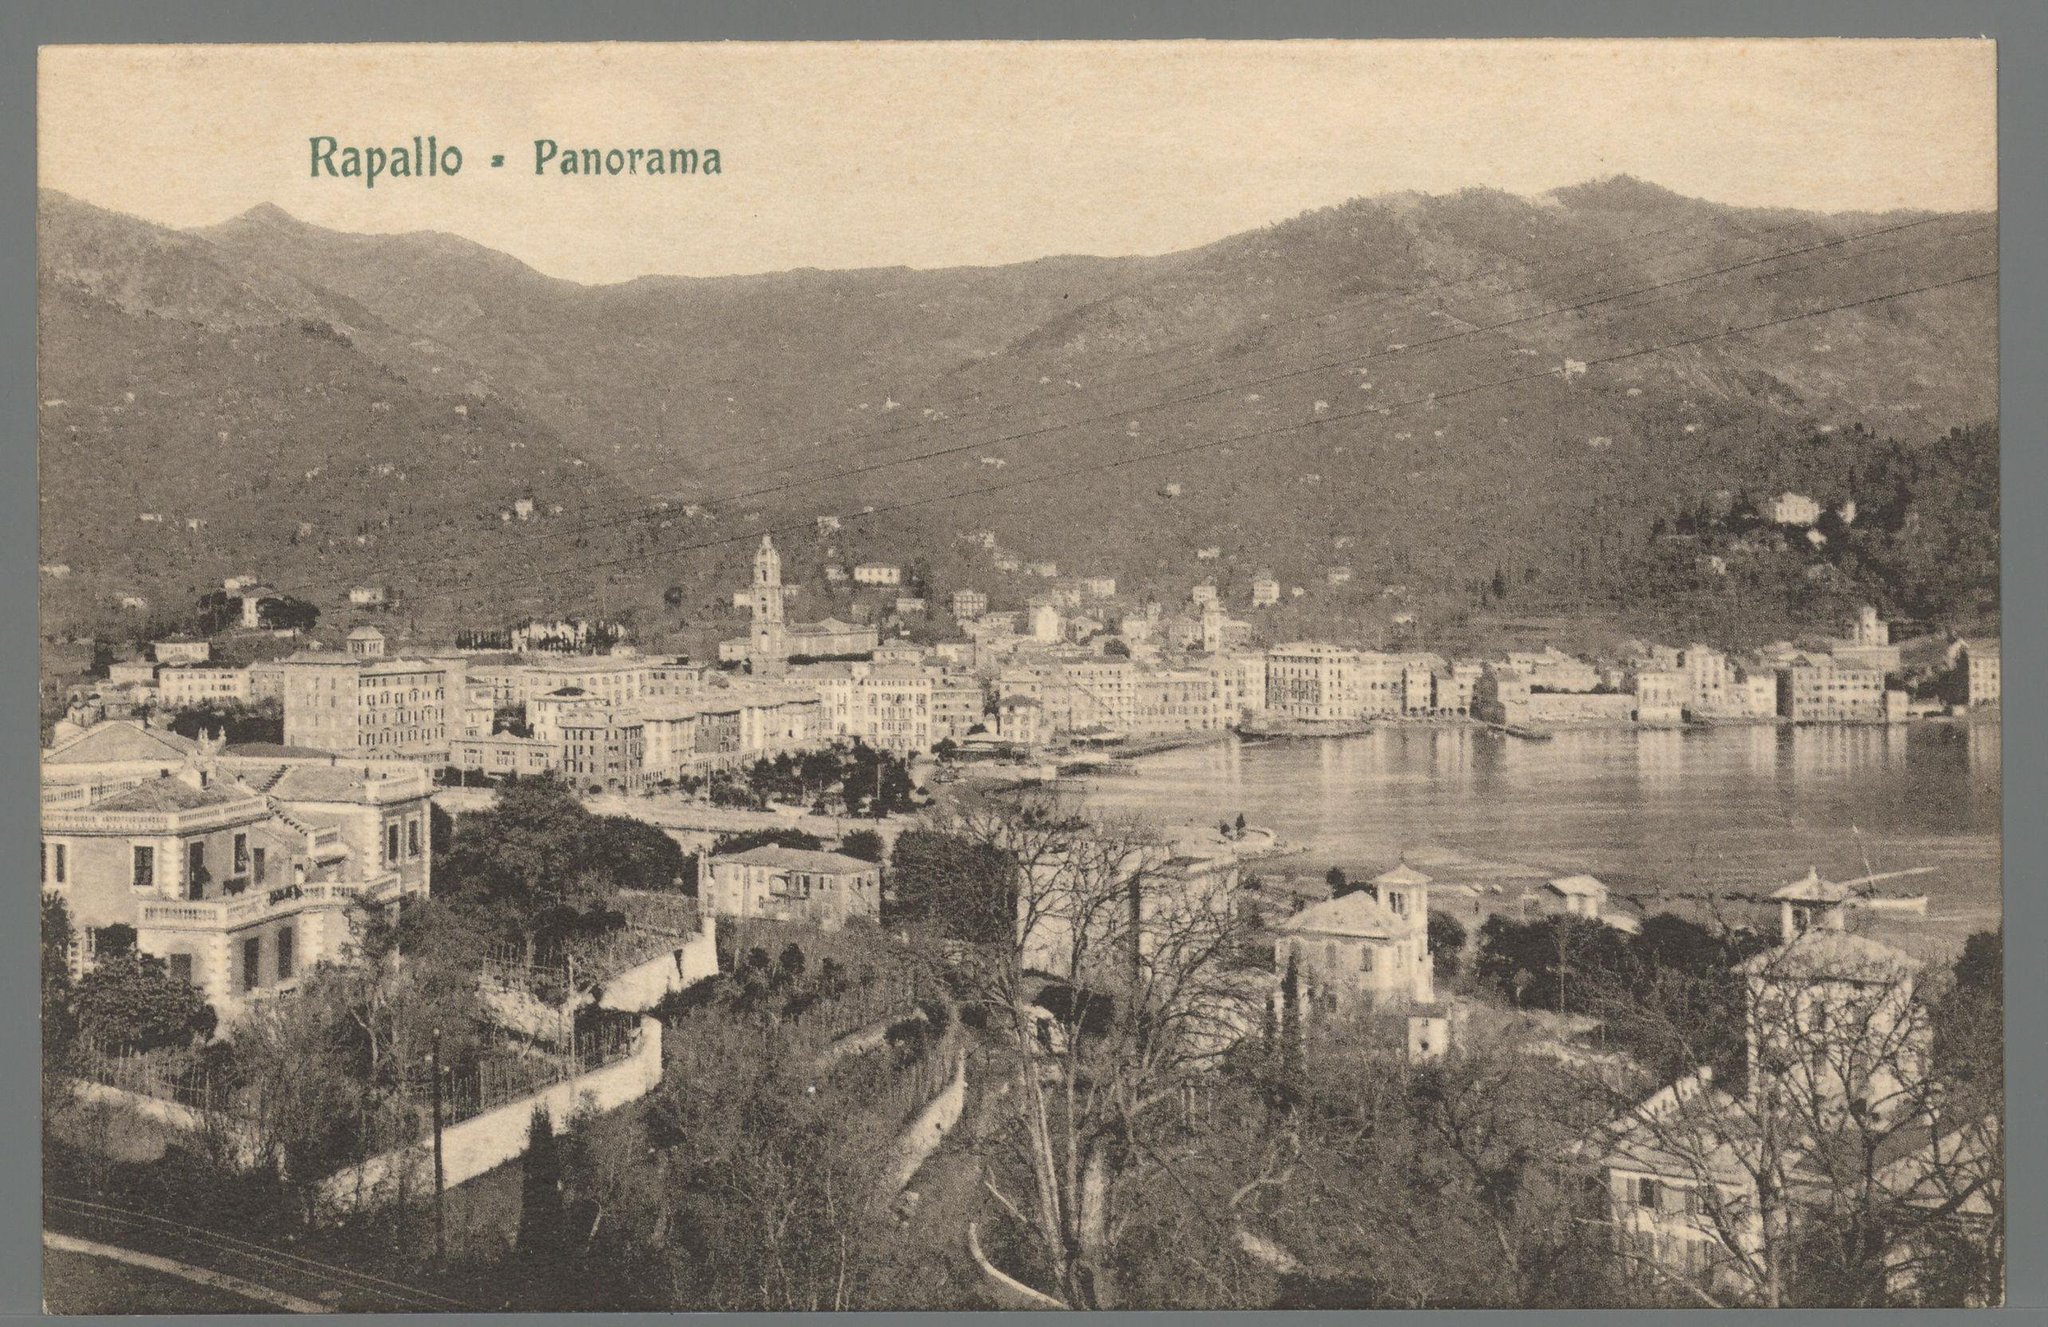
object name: ansichtkaart, prentbriefkaart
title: Rapallo. Panorama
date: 1906-1909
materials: cardboard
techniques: photograph, writing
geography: rapallo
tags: sea (seascape), prospect of city, town panorama, silhouette of city, mountains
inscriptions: mark: ‘M’